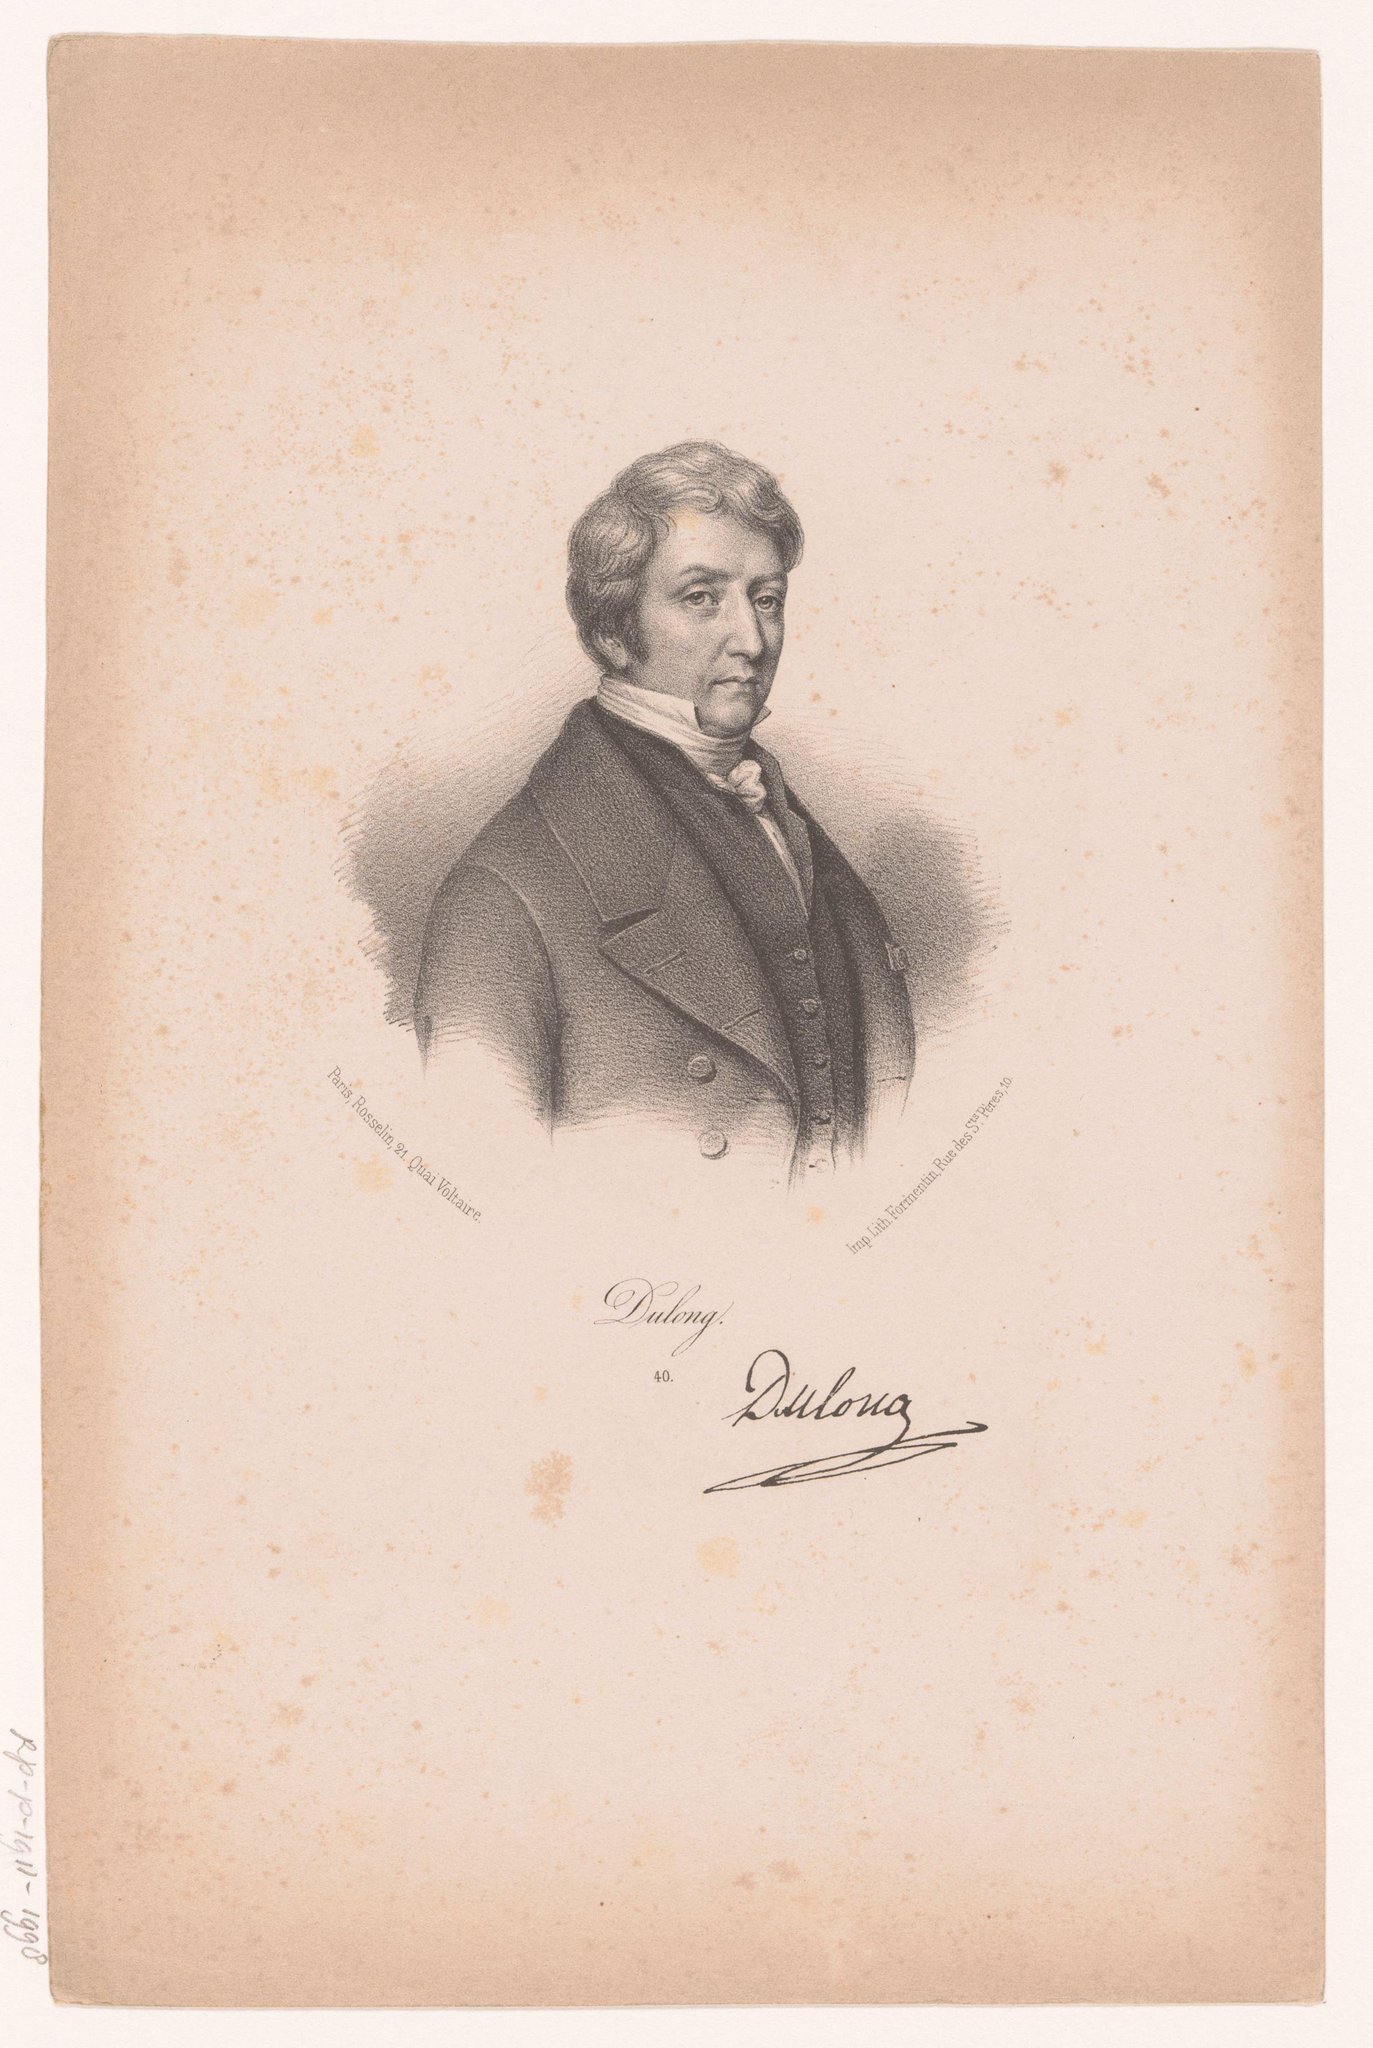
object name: print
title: Portret van Pierre Louis Dulong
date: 1830-1856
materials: paper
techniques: lithograph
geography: paris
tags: paris, physicist, historical persons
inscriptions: collector's mark: Lugt 2228a